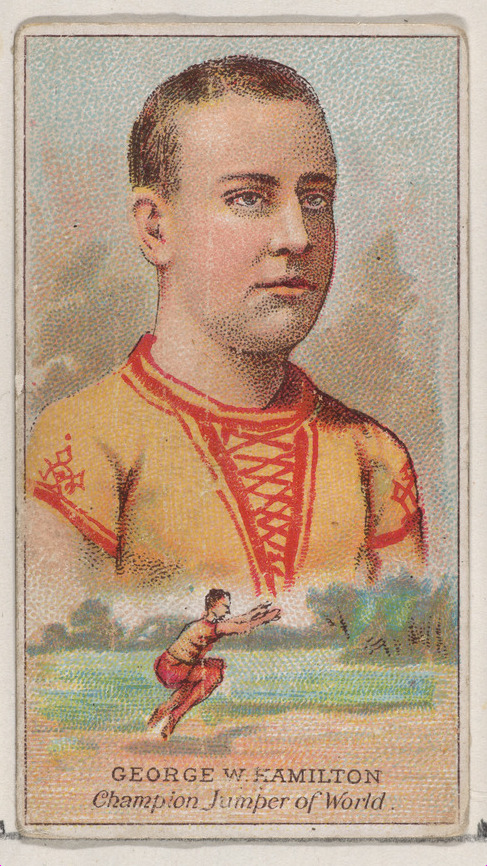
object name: print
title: George W. Hamilton, Champion Jumper of the World, from the Champions of Games and Sports series (N184, Type 2) issued by W.S. Kimball & Co.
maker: w.s. kimball & co.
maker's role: publisher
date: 1887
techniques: color lithograph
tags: men,sports,athletes